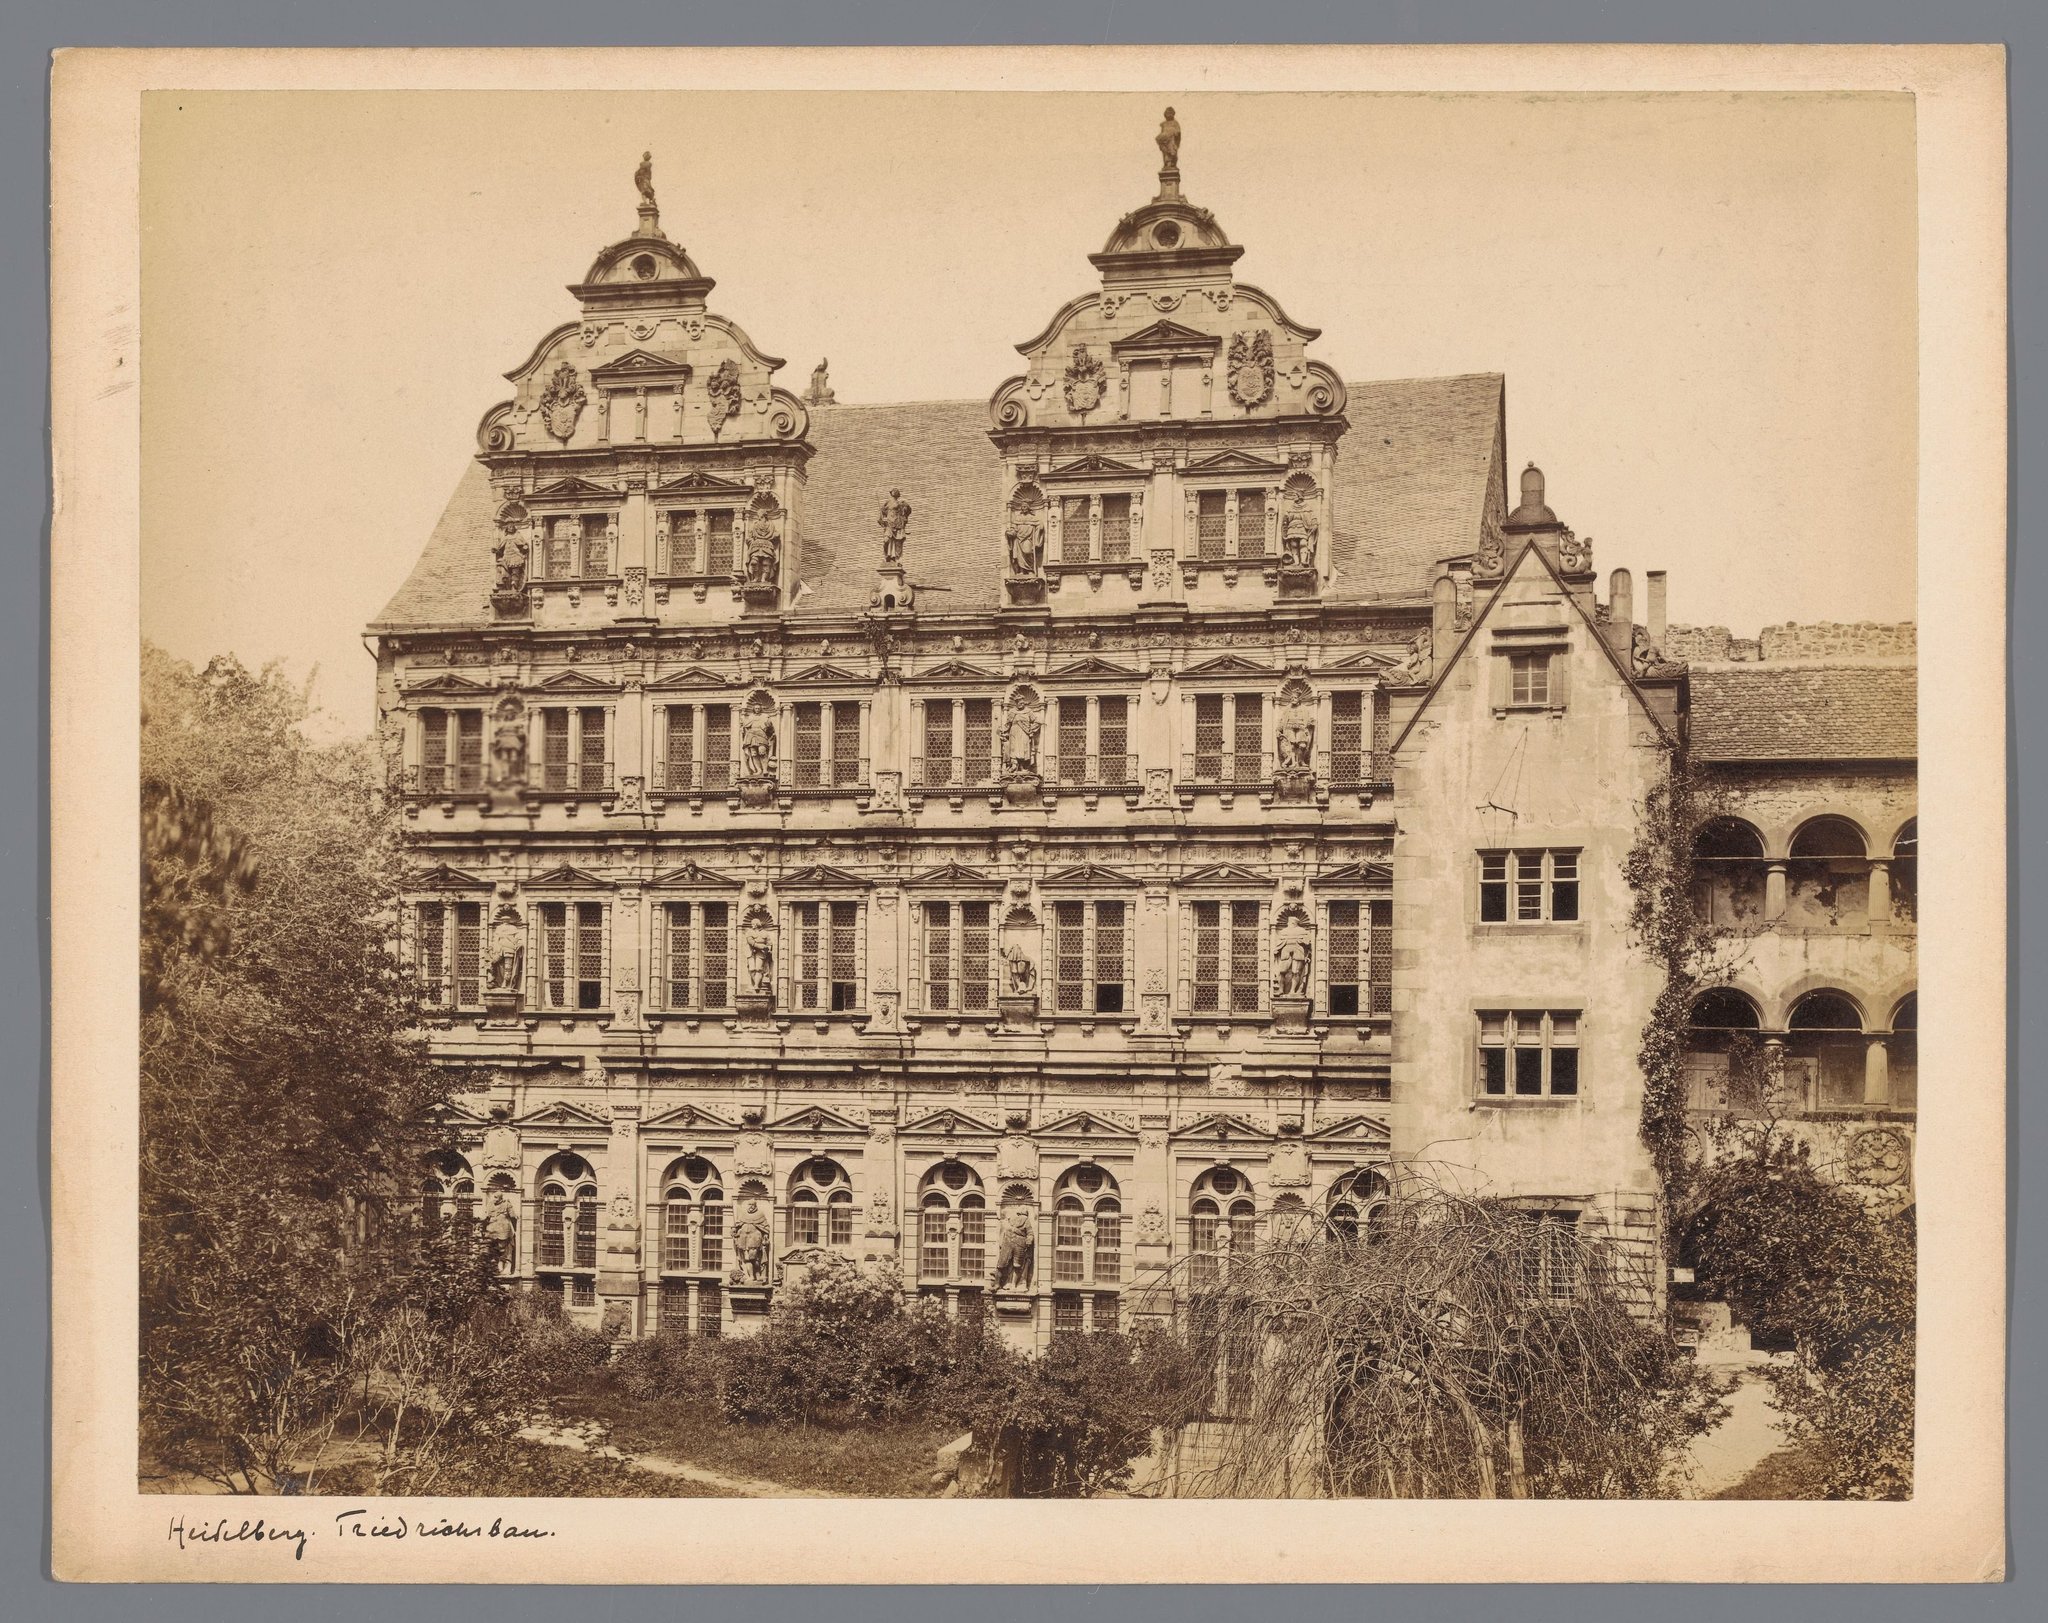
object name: photograph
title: Exterieur van de Friedrichsbau in Schloss Heidelberg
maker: Anonymous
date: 1855-1890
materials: cardboard, paper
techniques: albumen print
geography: heidelberg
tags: façade (of house or building)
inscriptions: inscription: ‘Heidelberg. Friedrichsbau’